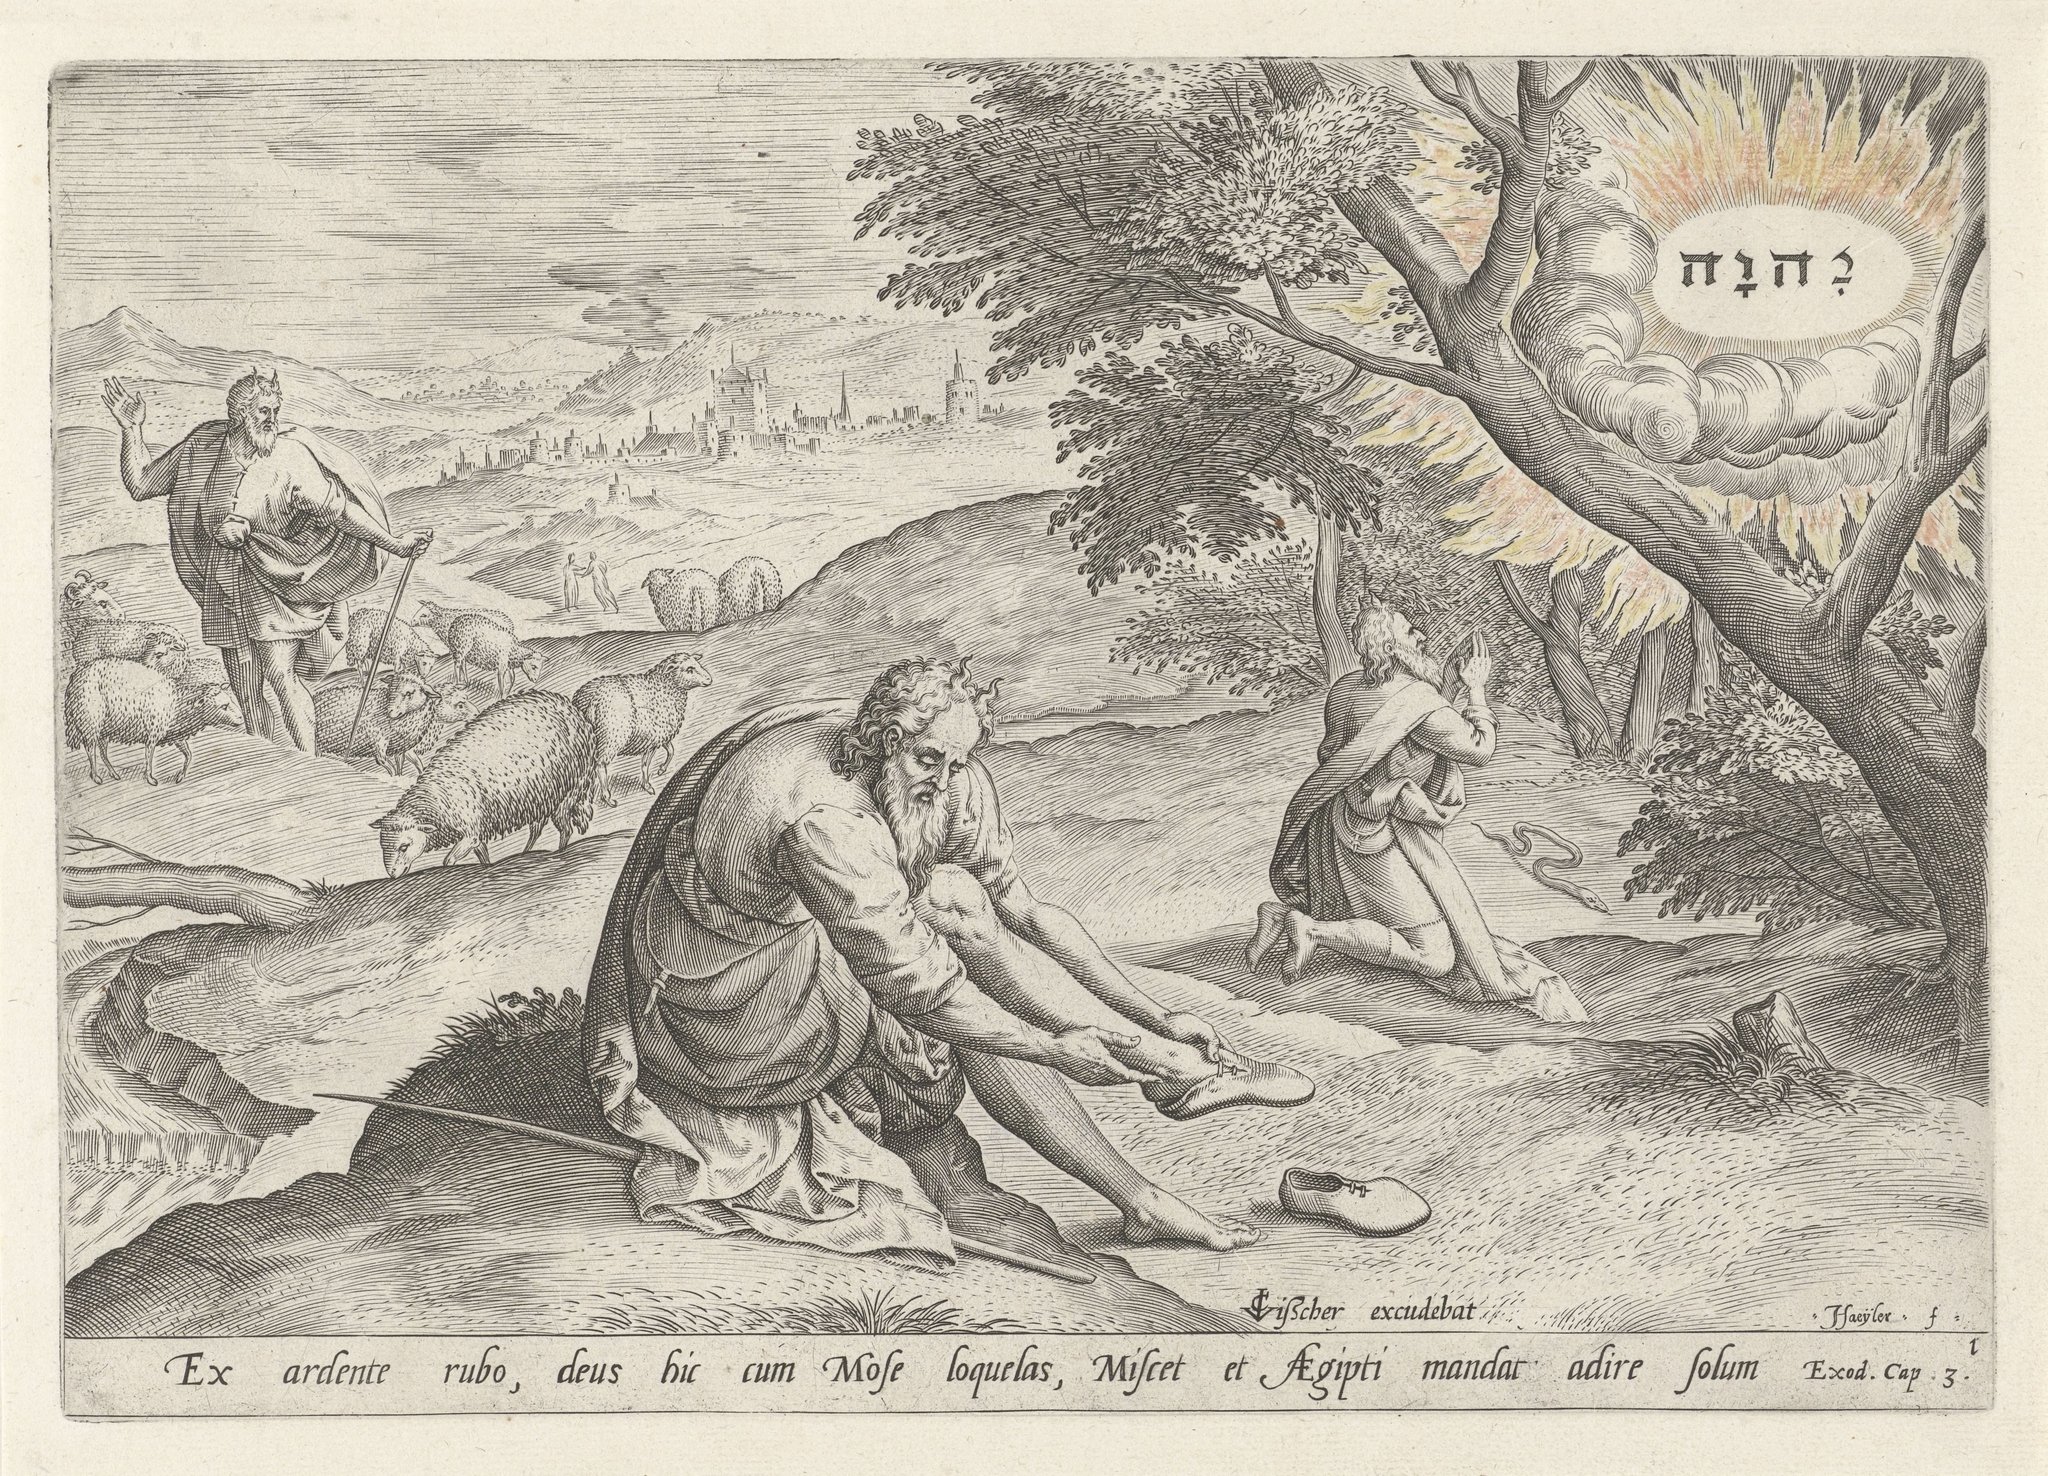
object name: print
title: God verschijnt aan Mozes in het brandende braambos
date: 1579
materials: paper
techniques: engraving, hand coloring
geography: amsterdam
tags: the calling of moses (exodus 3-4), tetragram (in roman or hebrew script) ~ symbol of god the father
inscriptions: collector's mark: Lugt 2228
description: Op de voorgrond trekt Mozes zijn schoenen uit. Op het tweede plan rechts knielt Mozes voor het brandende braambos waarboven het tetragram van God verschijnt. Op de achtergrond links hoedt Mozes schapen. De prent heeft een Latijns opschrift.